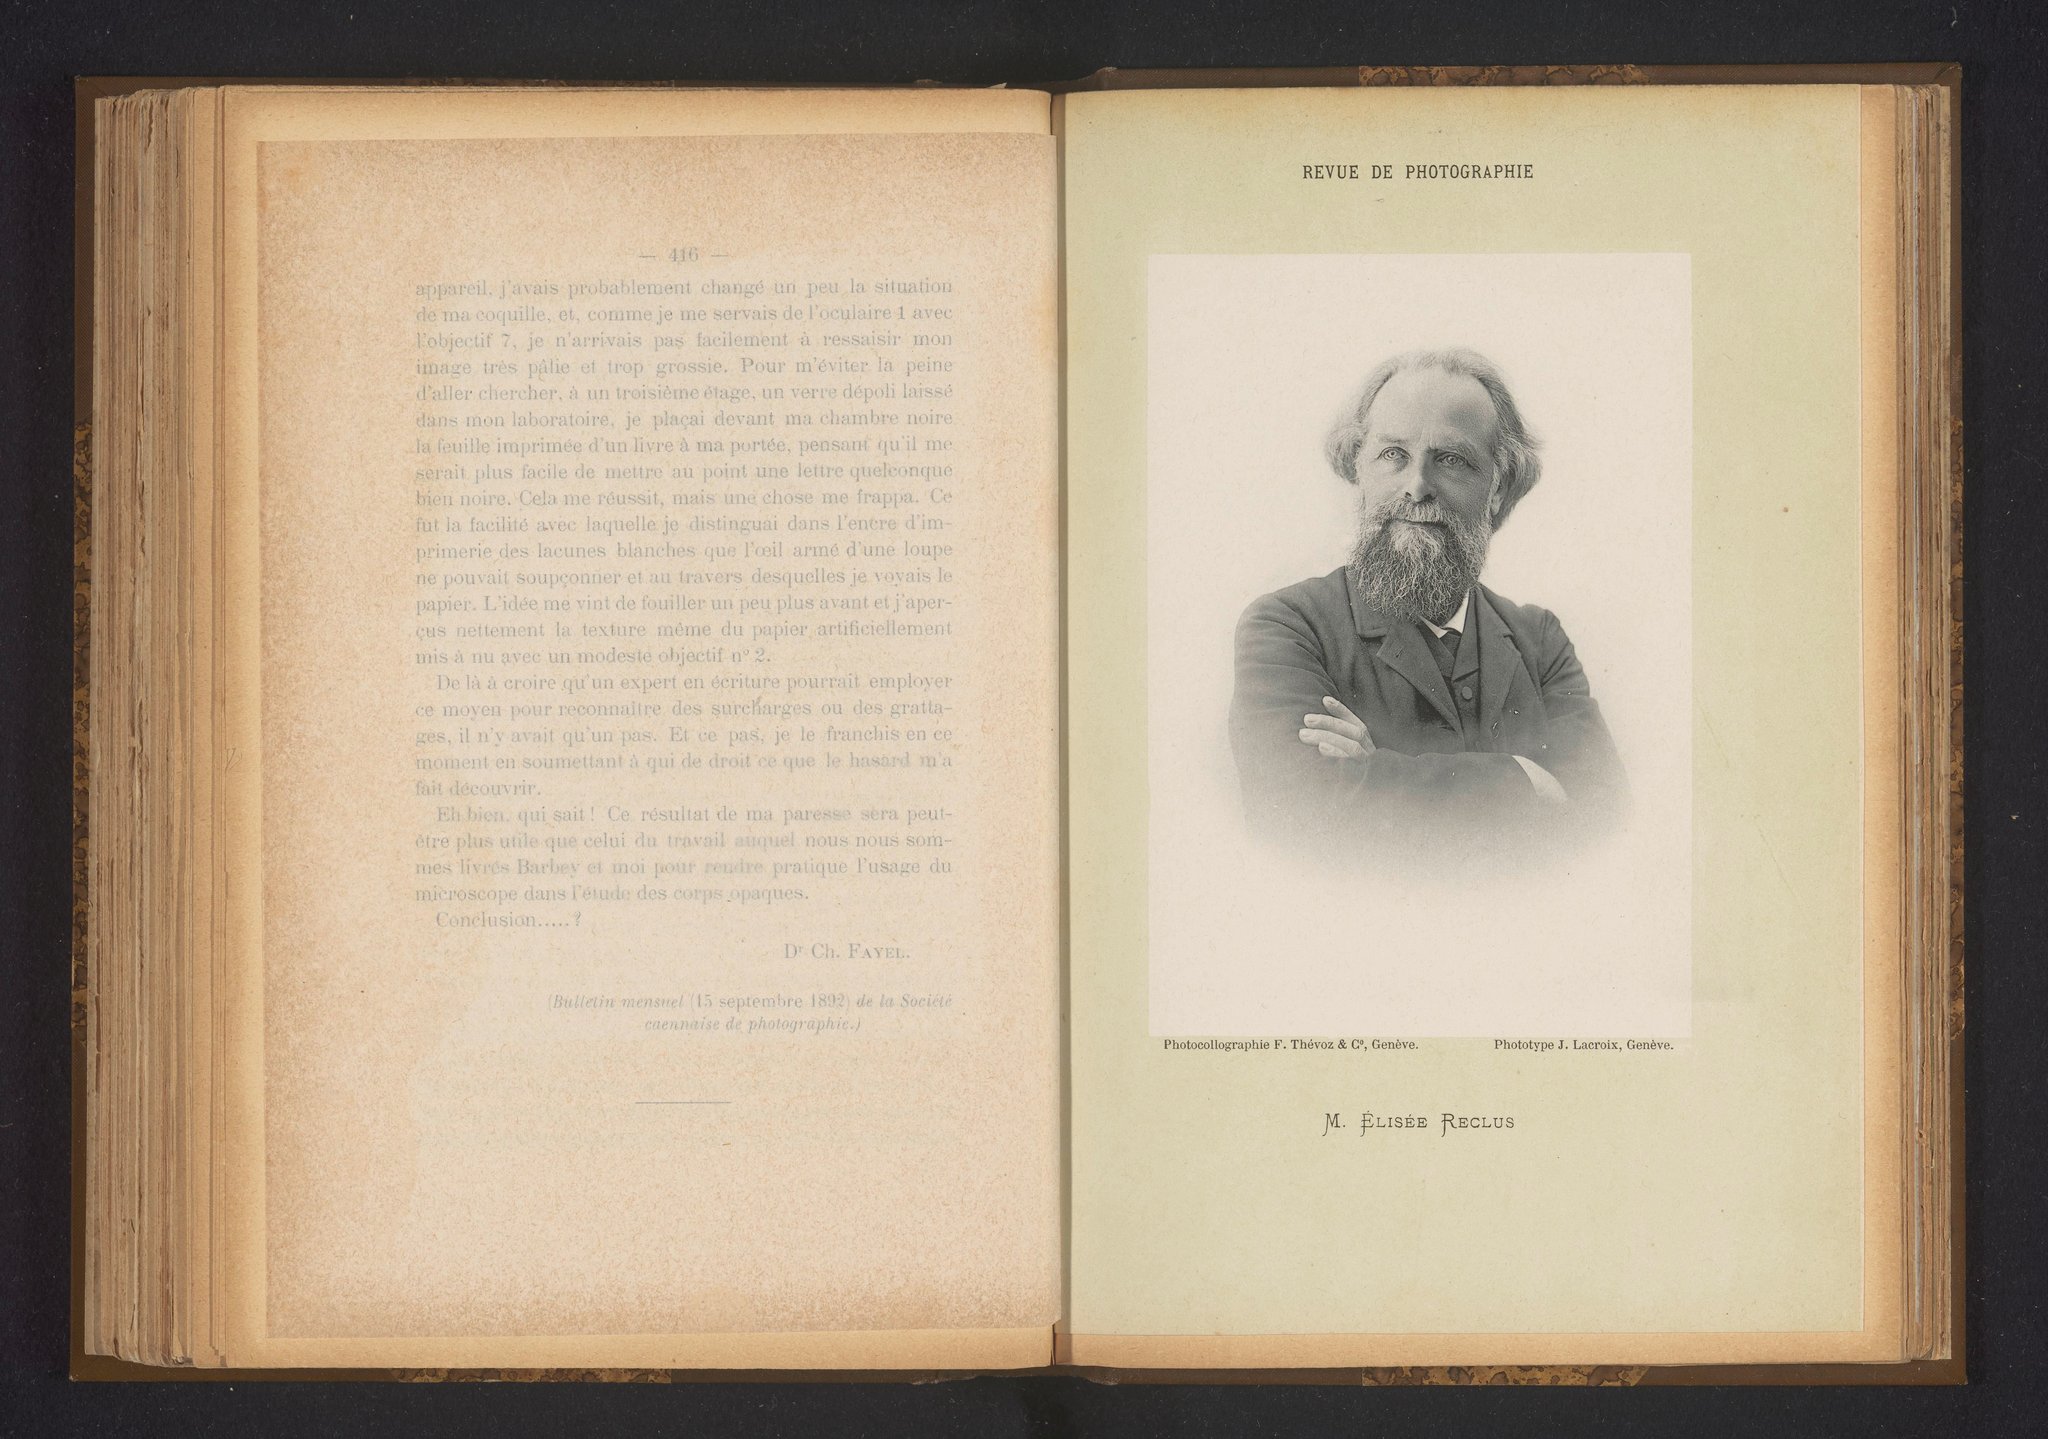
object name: page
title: Portret van Élisée Reclus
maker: jean lacroix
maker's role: printer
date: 1887-1892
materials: paper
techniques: photograph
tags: historical persons (portraits and scenes from the life)